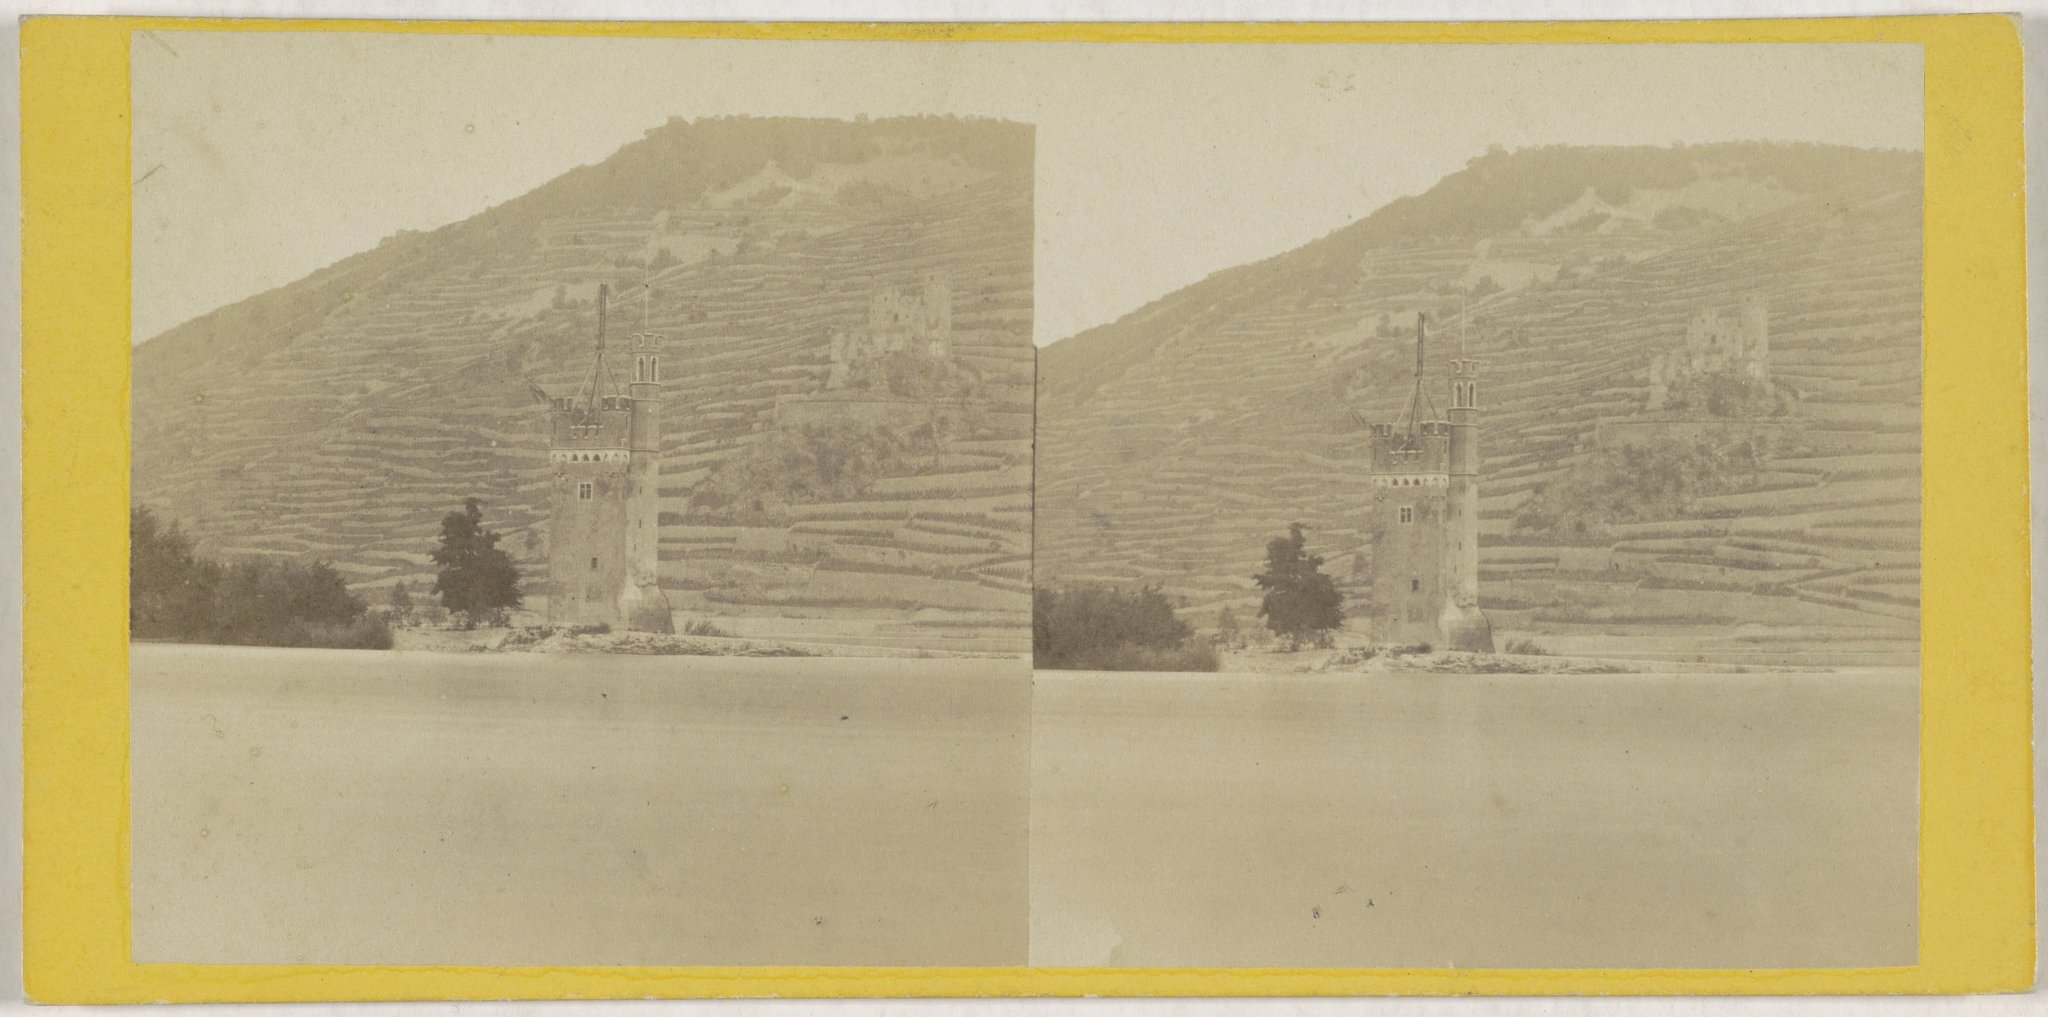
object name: stereograph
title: Tour de souris, Rhin et château de Ehrenfels à Bingen, Prusse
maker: Anonymous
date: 1861-1870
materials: cardboard, paper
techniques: albumen print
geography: bingen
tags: river, landscape with tower or castle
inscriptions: number: ‘121’